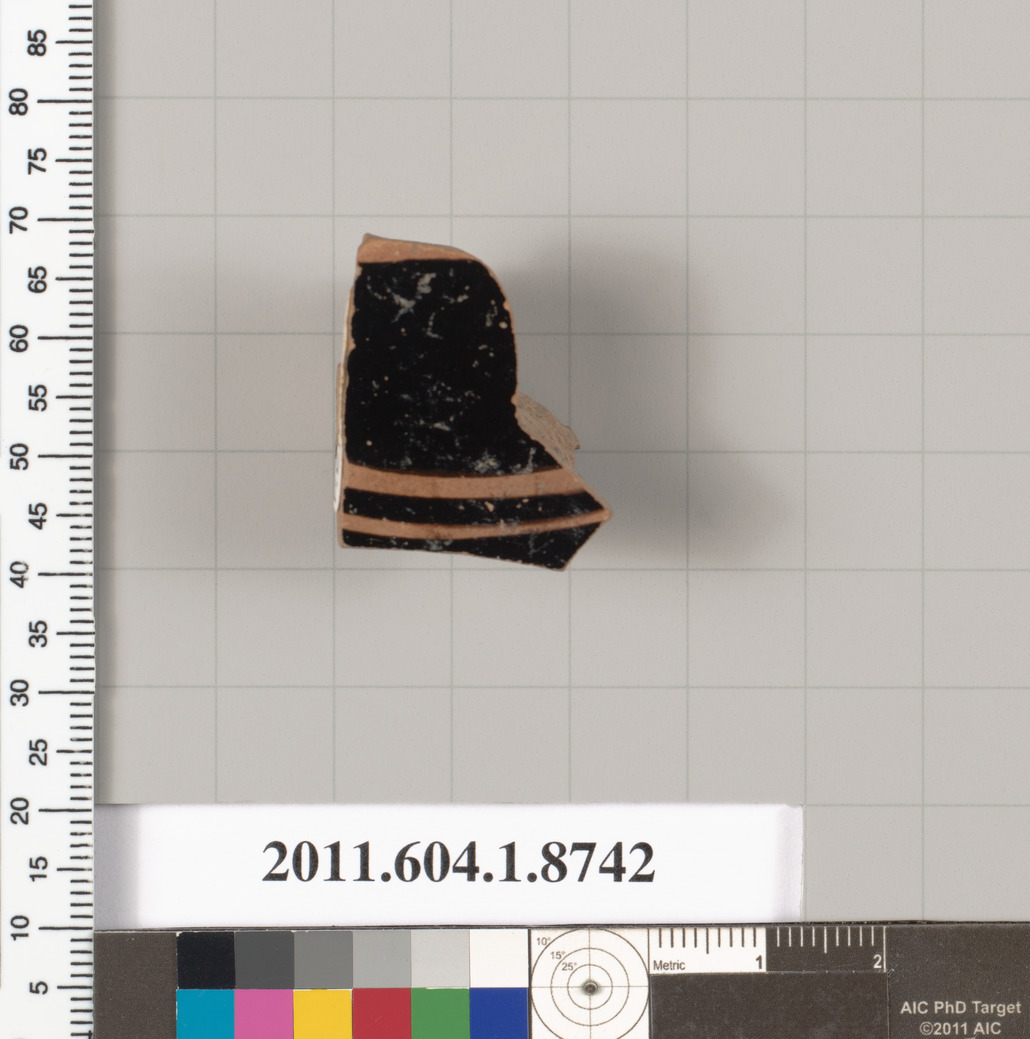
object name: kylix fragment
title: Terracotta fragment of a stemless cup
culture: greek, attic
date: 475-451 BCE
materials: terracotta